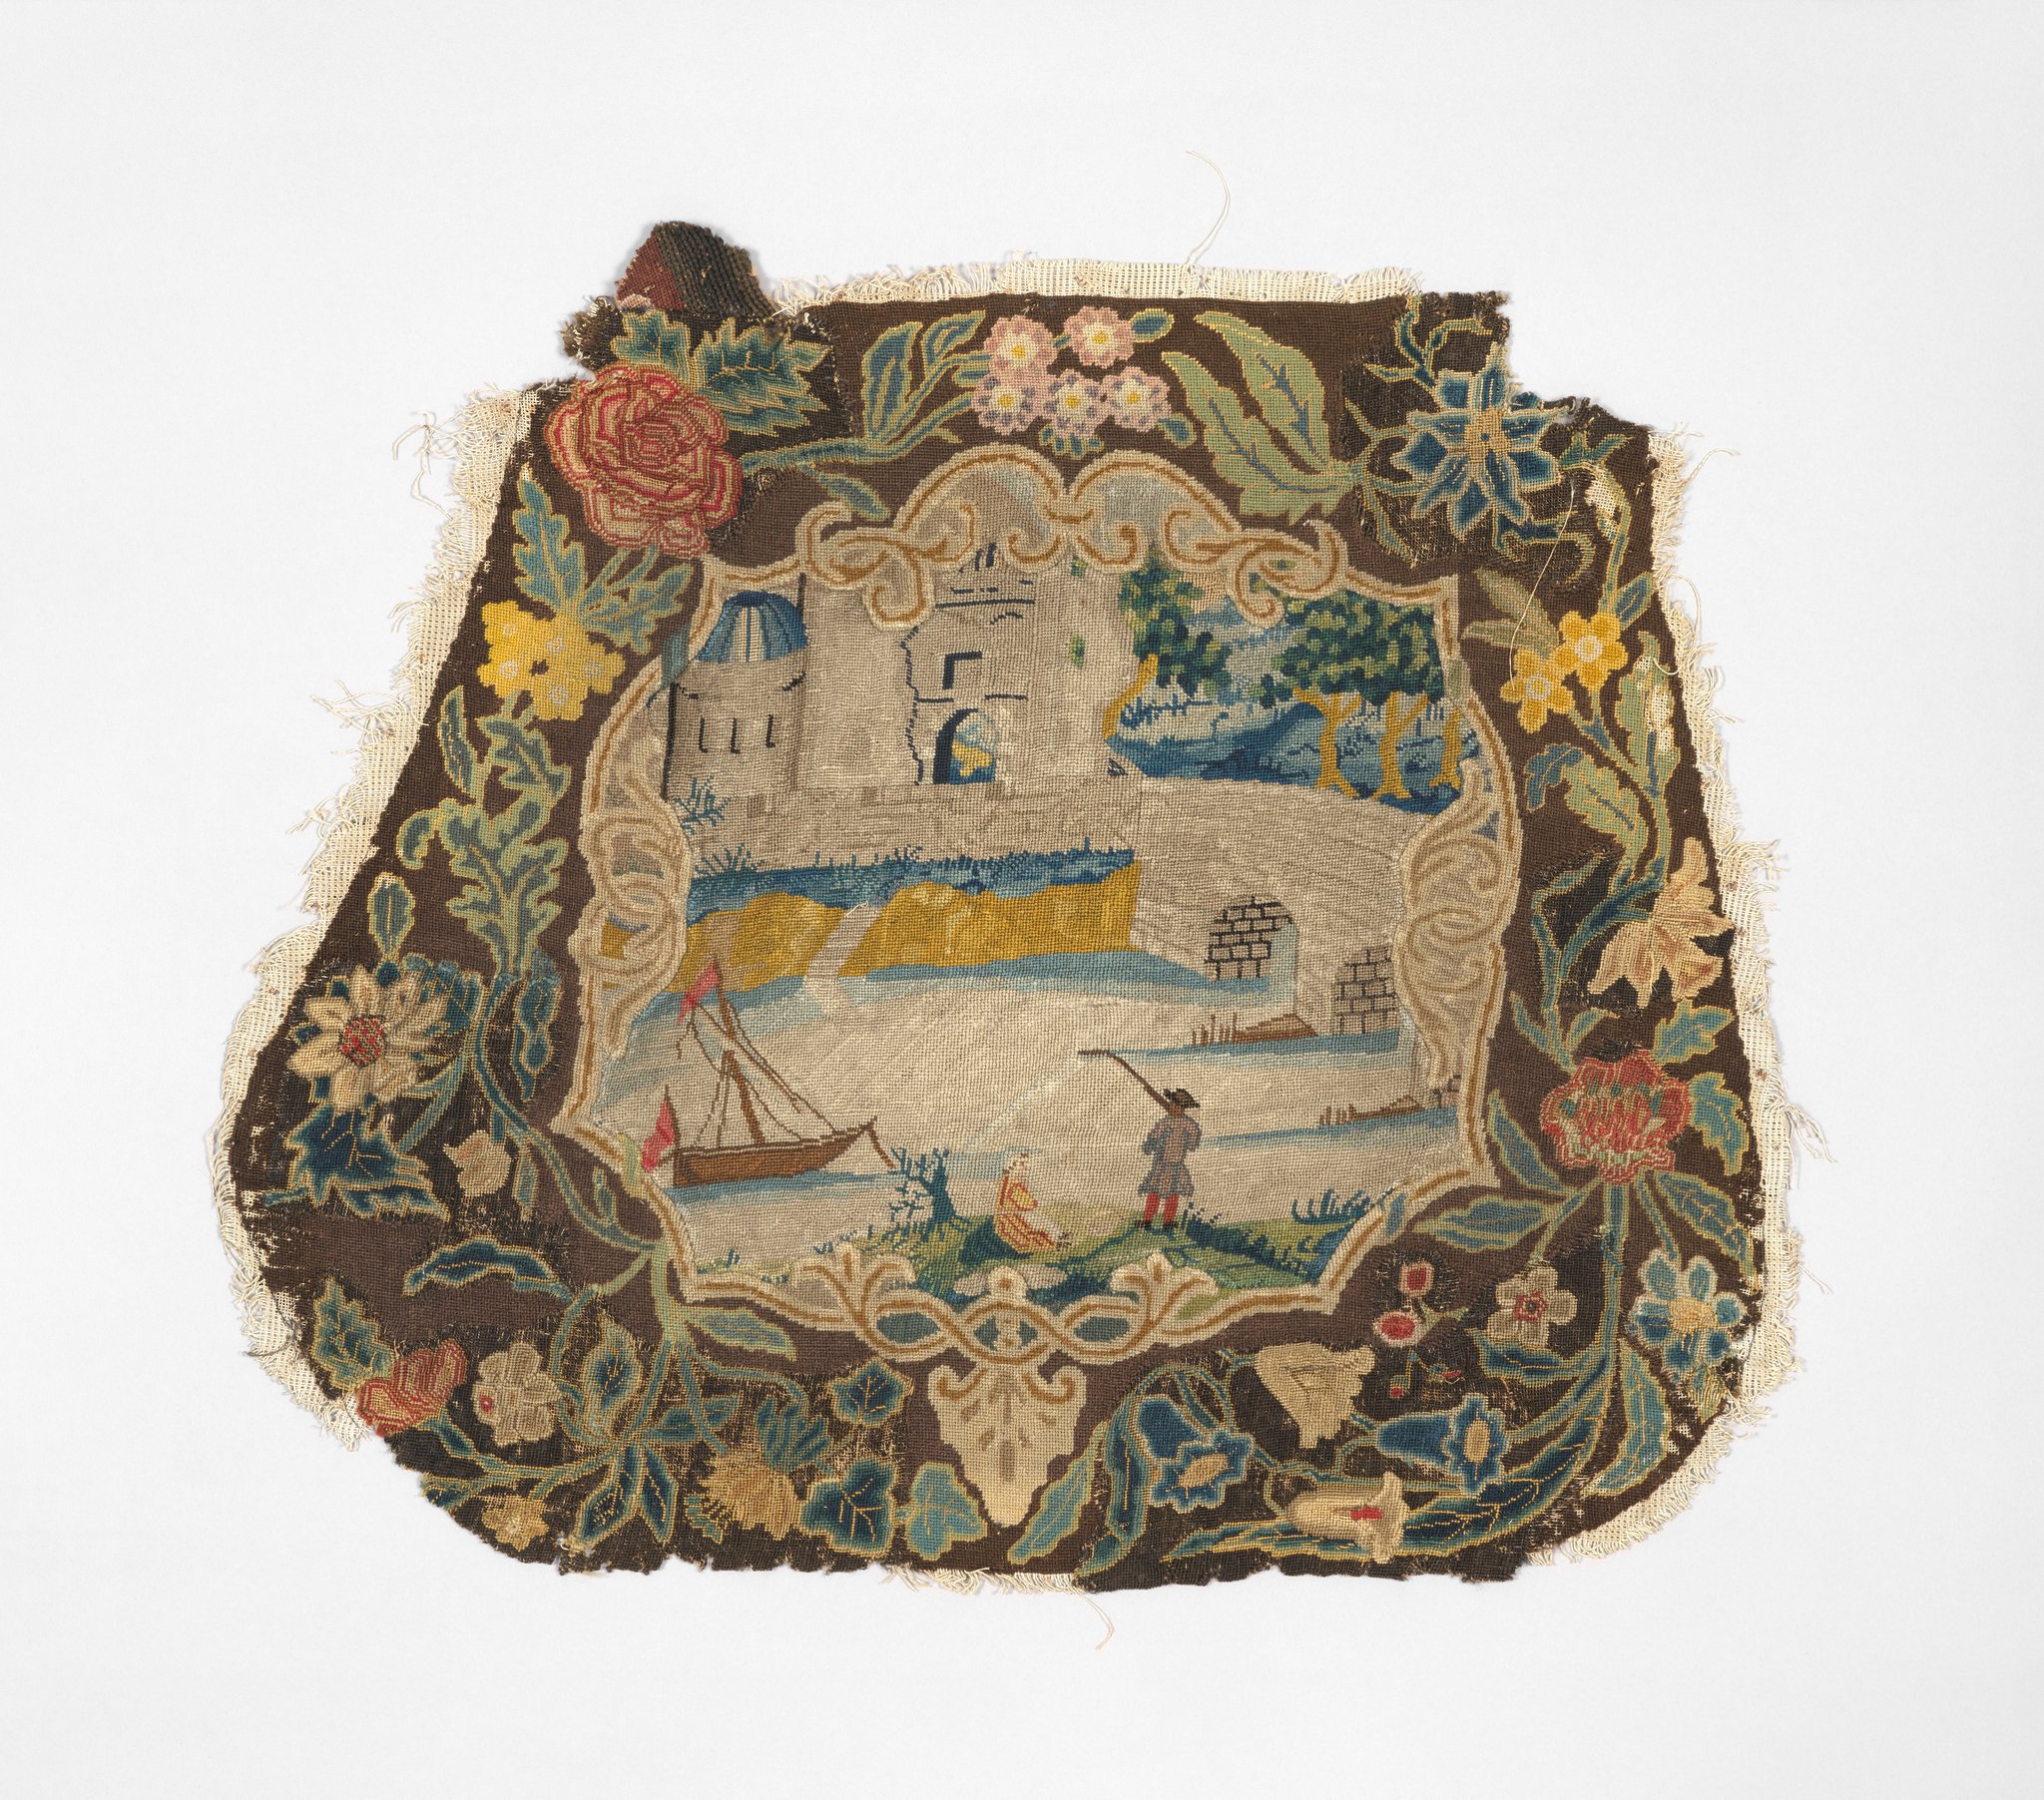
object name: cover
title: Chair seat cover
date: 1734-1766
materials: canvas, silk, wool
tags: human figures,flowers,boats